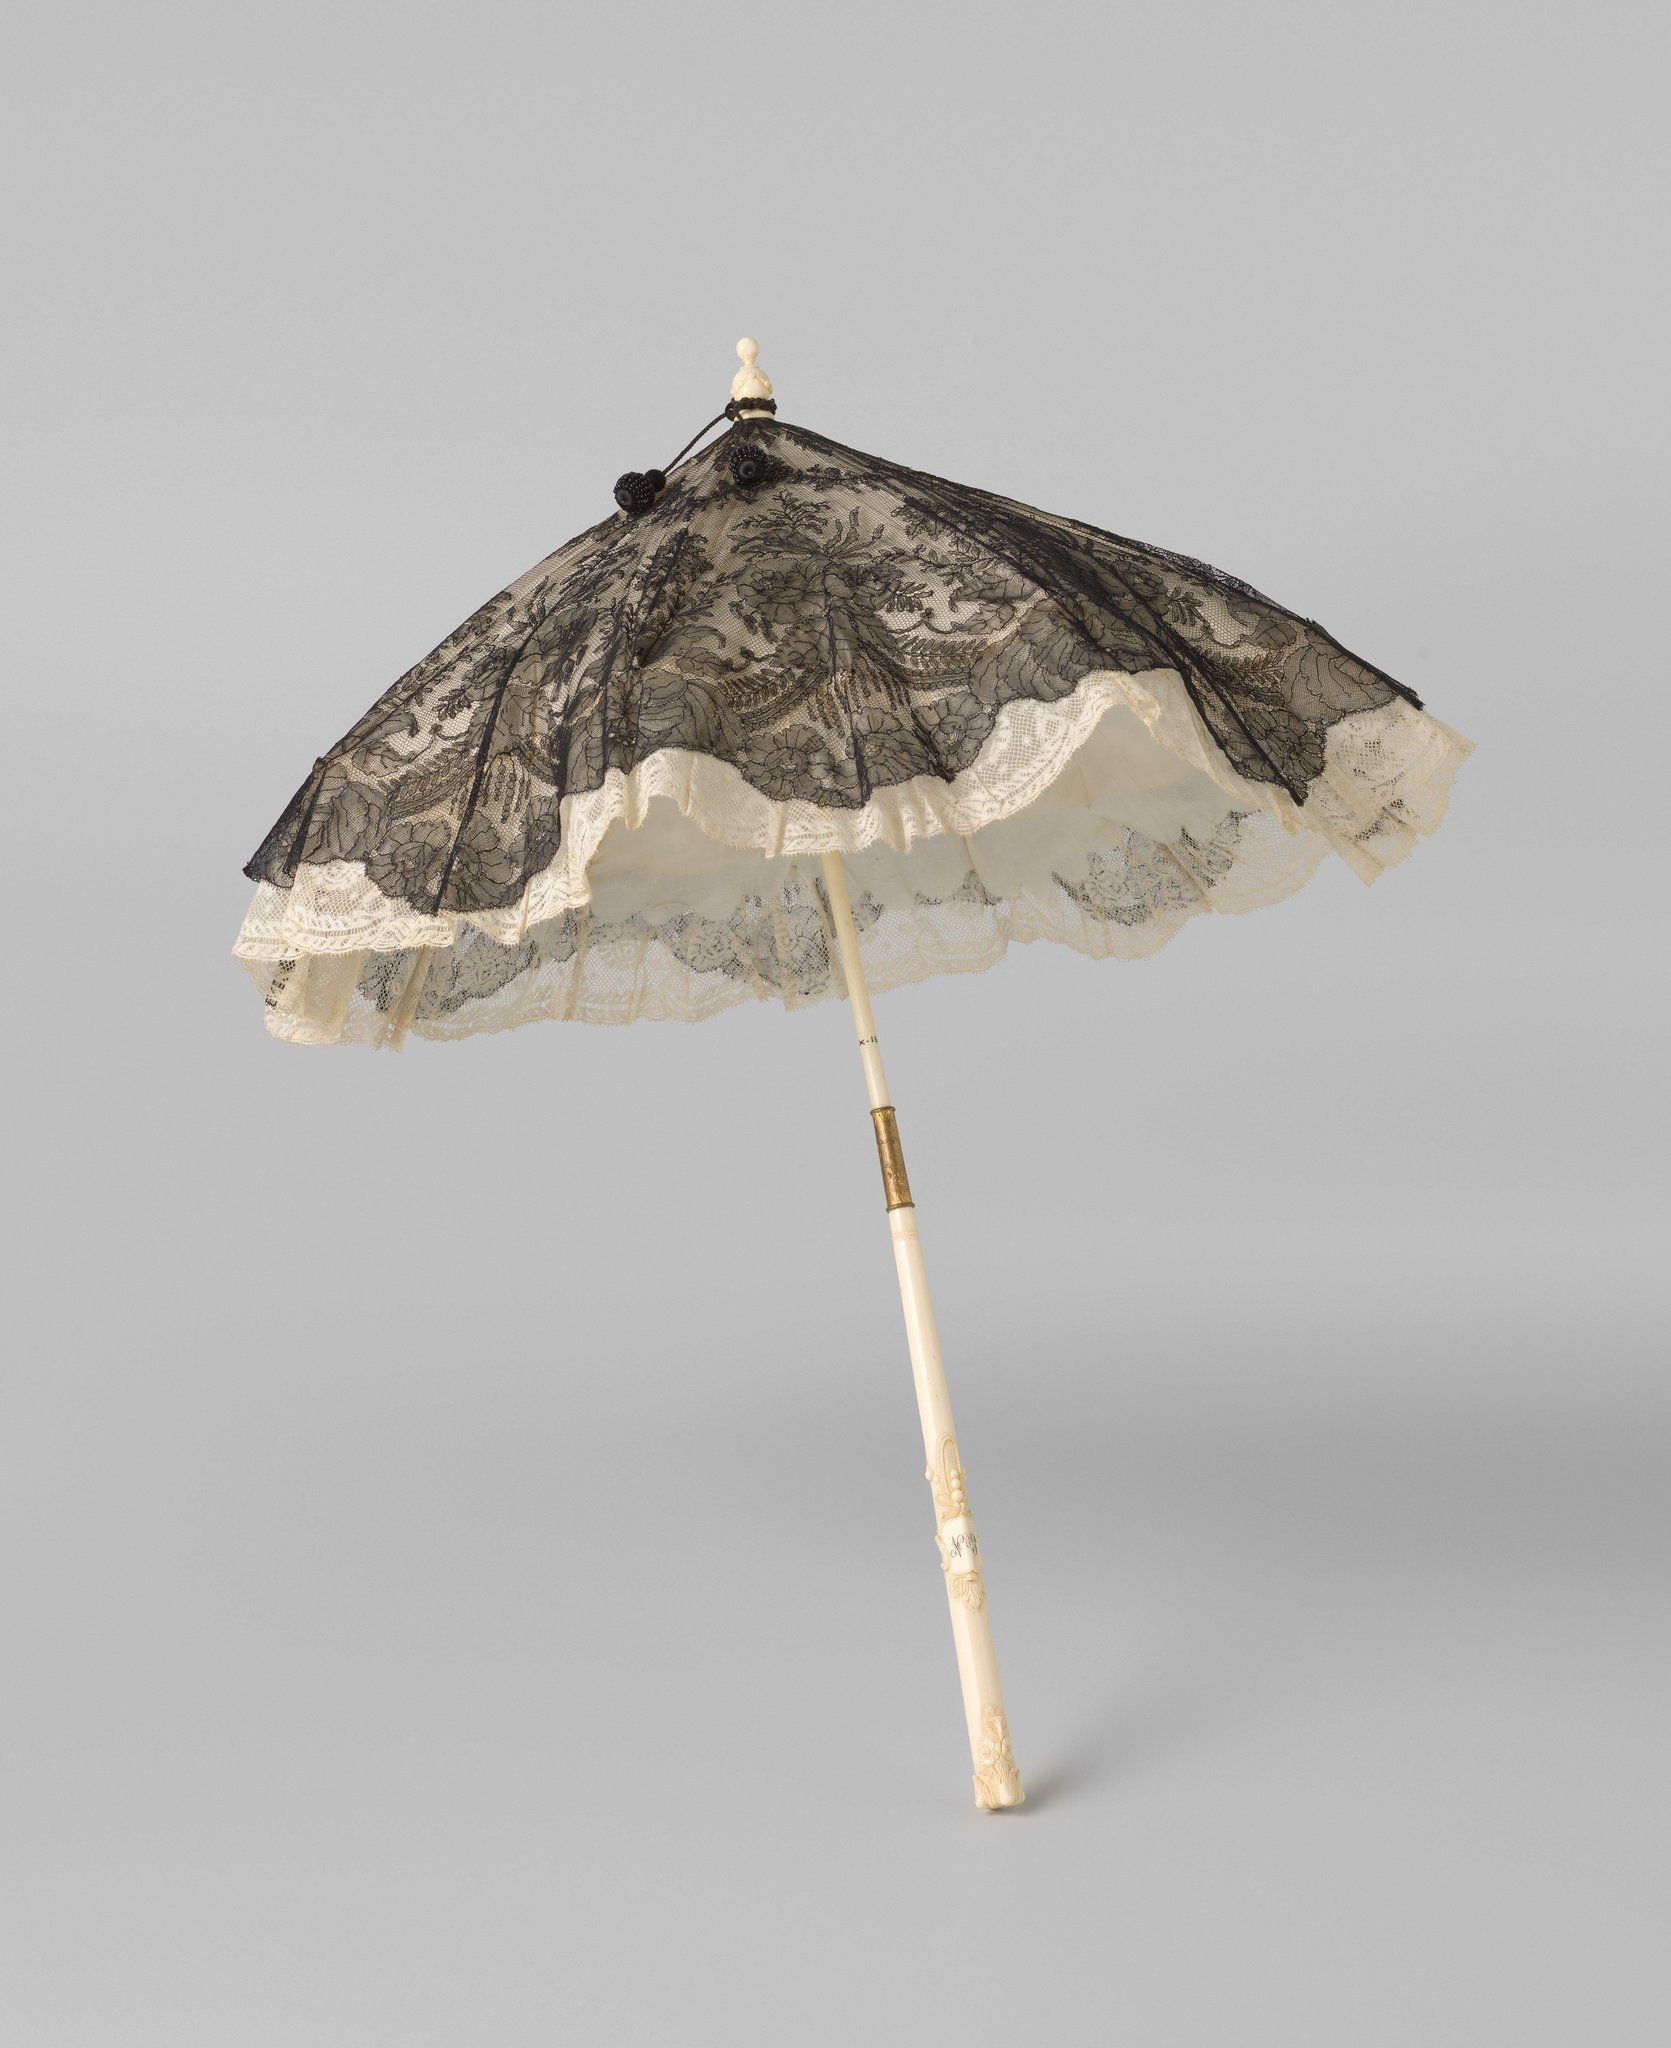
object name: carriage parasol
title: Parasol met een dek van Chantillykant afgezet met een strook witte katoenen kloskant en gevoerd met witte tafzijde op een stok van gesneden ivoor waarop de initialen 'EVN'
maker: Anonymous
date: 1855-1875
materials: copper, cotton, ivory, jet, silk, textile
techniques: braiding, lace, cutting, weave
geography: bayeux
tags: emilie regina van nierop-gompetz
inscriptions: initials: ‘EVN’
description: Parasol met een dek van Chantilly (zwarte zijden kloskant) afgezet met een strook Valenciennes (witte katoenen kloskant) en gevoerd met witte tafzijde op een stok van gesneden ivoor. Het Chantilly dek heeft in het midden een sterornament, gevormd door bladeren, en is omringd door een ijle guirlande. Hieronder boeketjes met rozen, een tulp en andere bloemen, die door banderollen van lint en bladeren verbonden zijn met grote hangende rozen, waarboven een symmetrische plaatsing van bloemen en bladeren. Een rand van drie rozen onder ieder boeketje. Onderaan een strook Valenciennes met rozen en een bladerrand. De opvouwbare, ivoren steel is versierd met een ornament in reliëf waarin de initialen 'EVN'. (Emilie Regina van Nierop-Gompertz gebruikte de initialen EvN) Om de urnvormige ivoren punt is een zwart zijden koord gewikkeld waaraan bollen versiers met gitten.